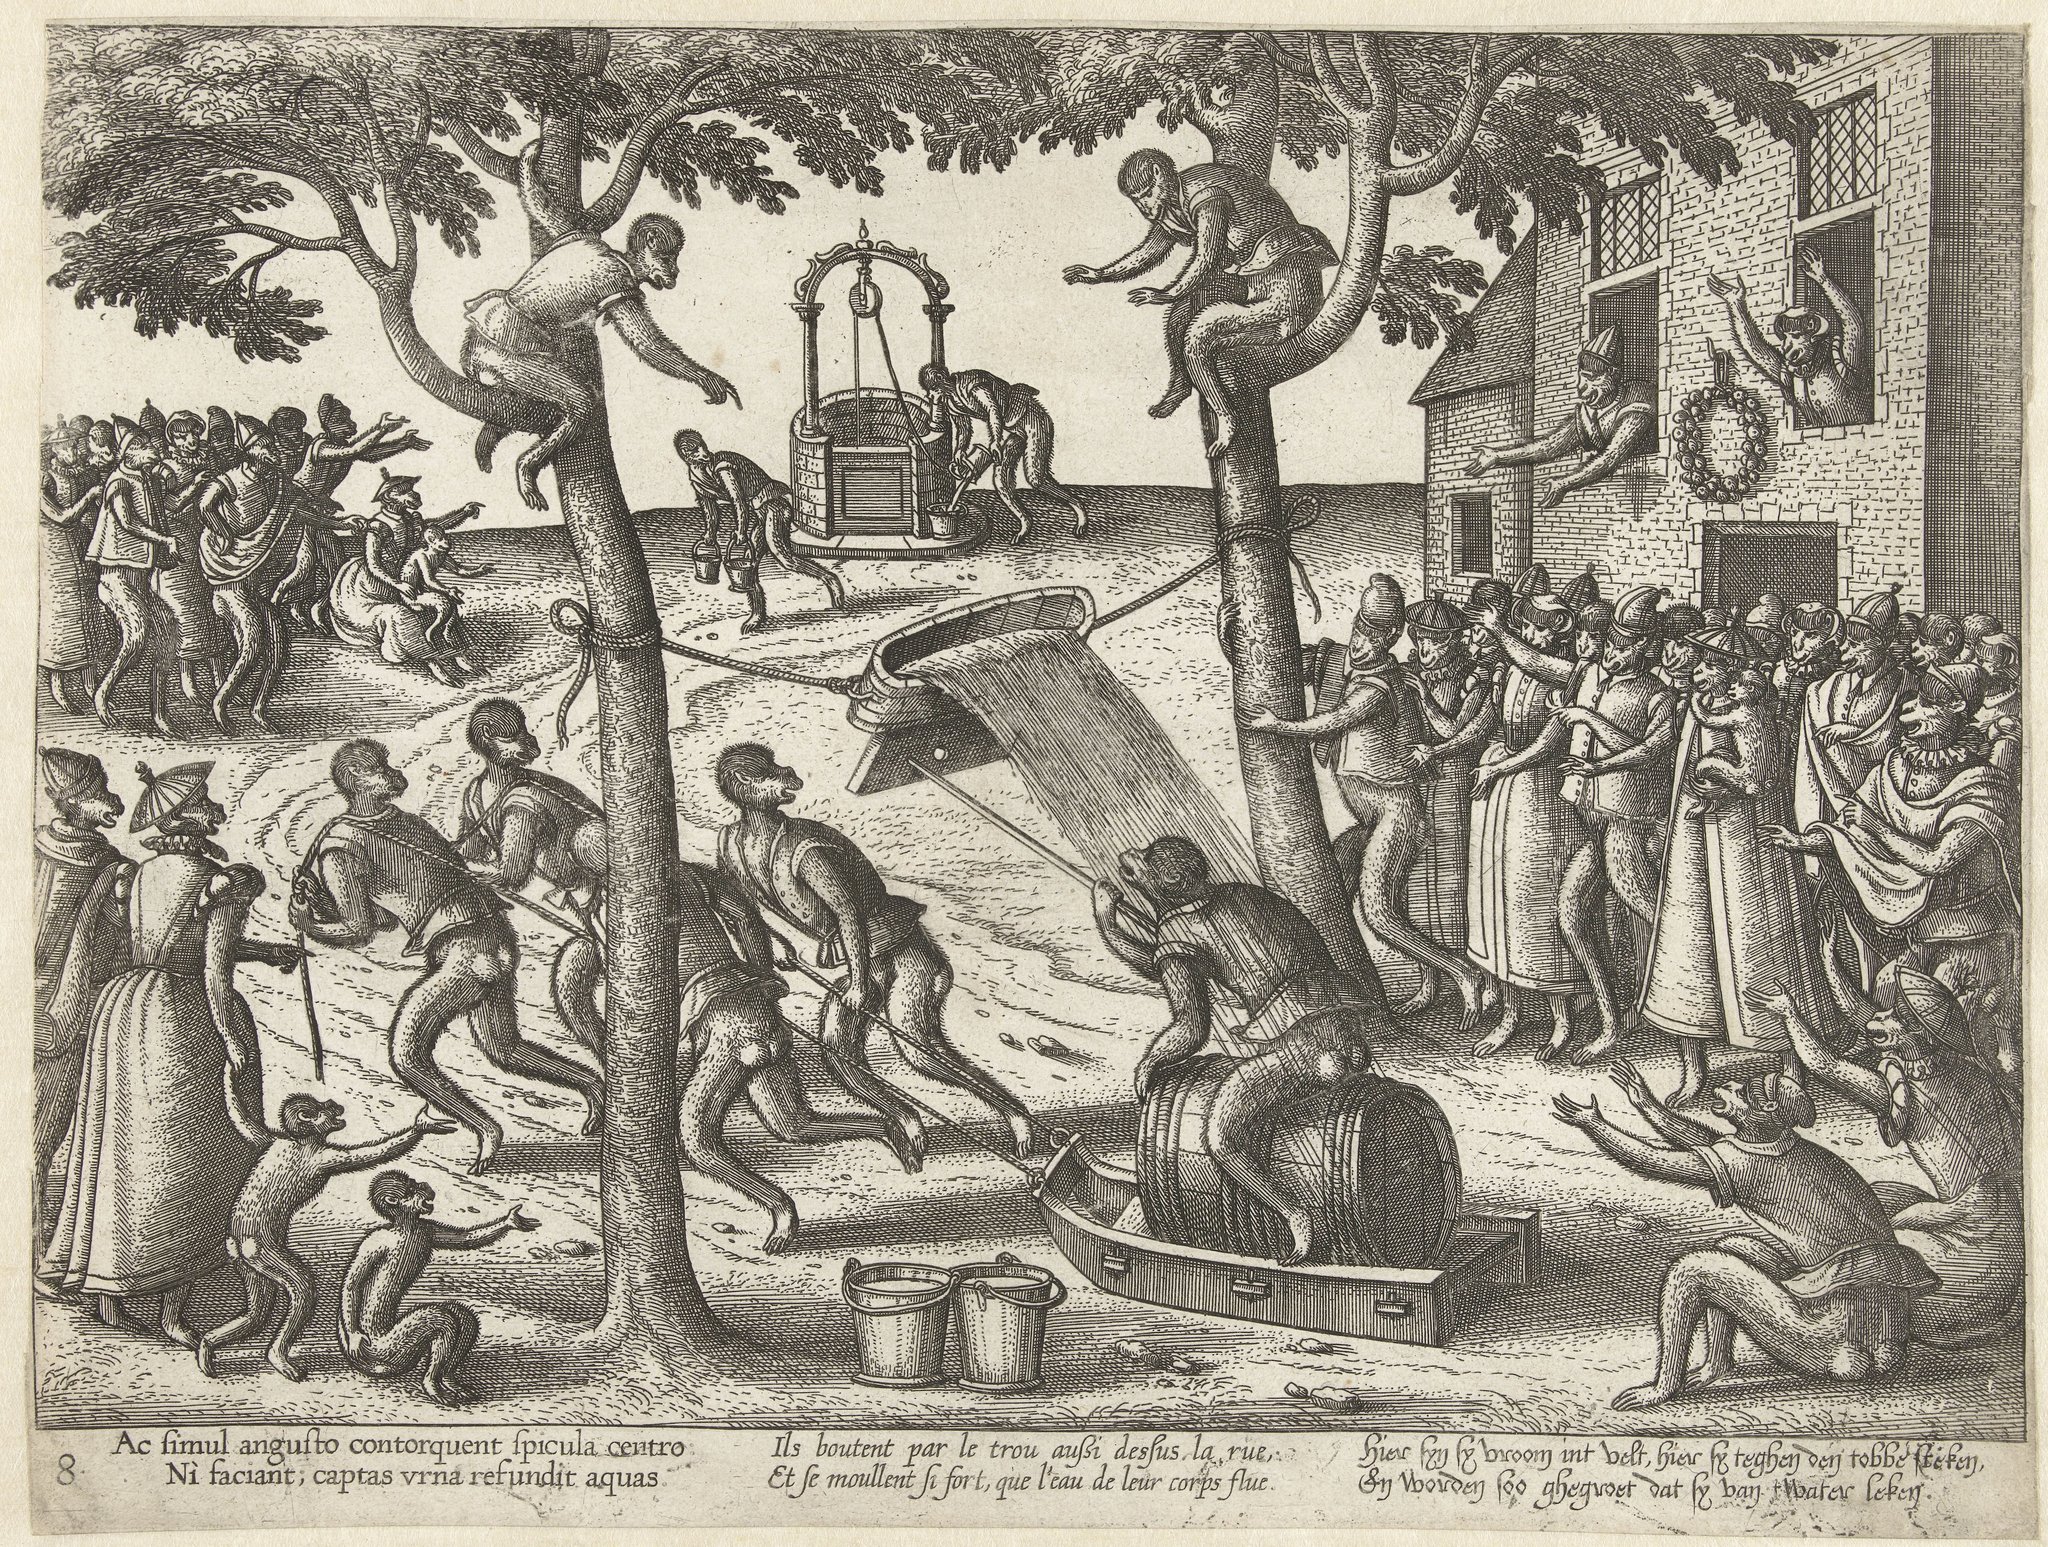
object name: print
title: Tobbespel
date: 1545-1608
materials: paper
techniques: etching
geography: antwerp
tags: drumming-up the public, tilting at the ring (~ games of skill)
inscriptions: collector's mark: Lugt 2228, collector's mark: Lugt 2760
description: De prent toont een volksvermaak uit de 16de eeuw: tobbespel of kuipsteken. Het spel wordt gespeeld door apen. Een tobbe, gevuld met water, is tussen twee bomen gehangen. Voortgetrokken op een ton proberen jongeren met een lans door een gat in de tobbe te steken. Wie succesvol is, wordt niet nat. Een menigte juicht een jonge aap toe, terwijl hij zijn kans waagt. Zijn poging is mislukt en de volle tobbe met water kantelt over hem heen. Een onderschrift van twee regels in het Frans, Nederland en Latijn.